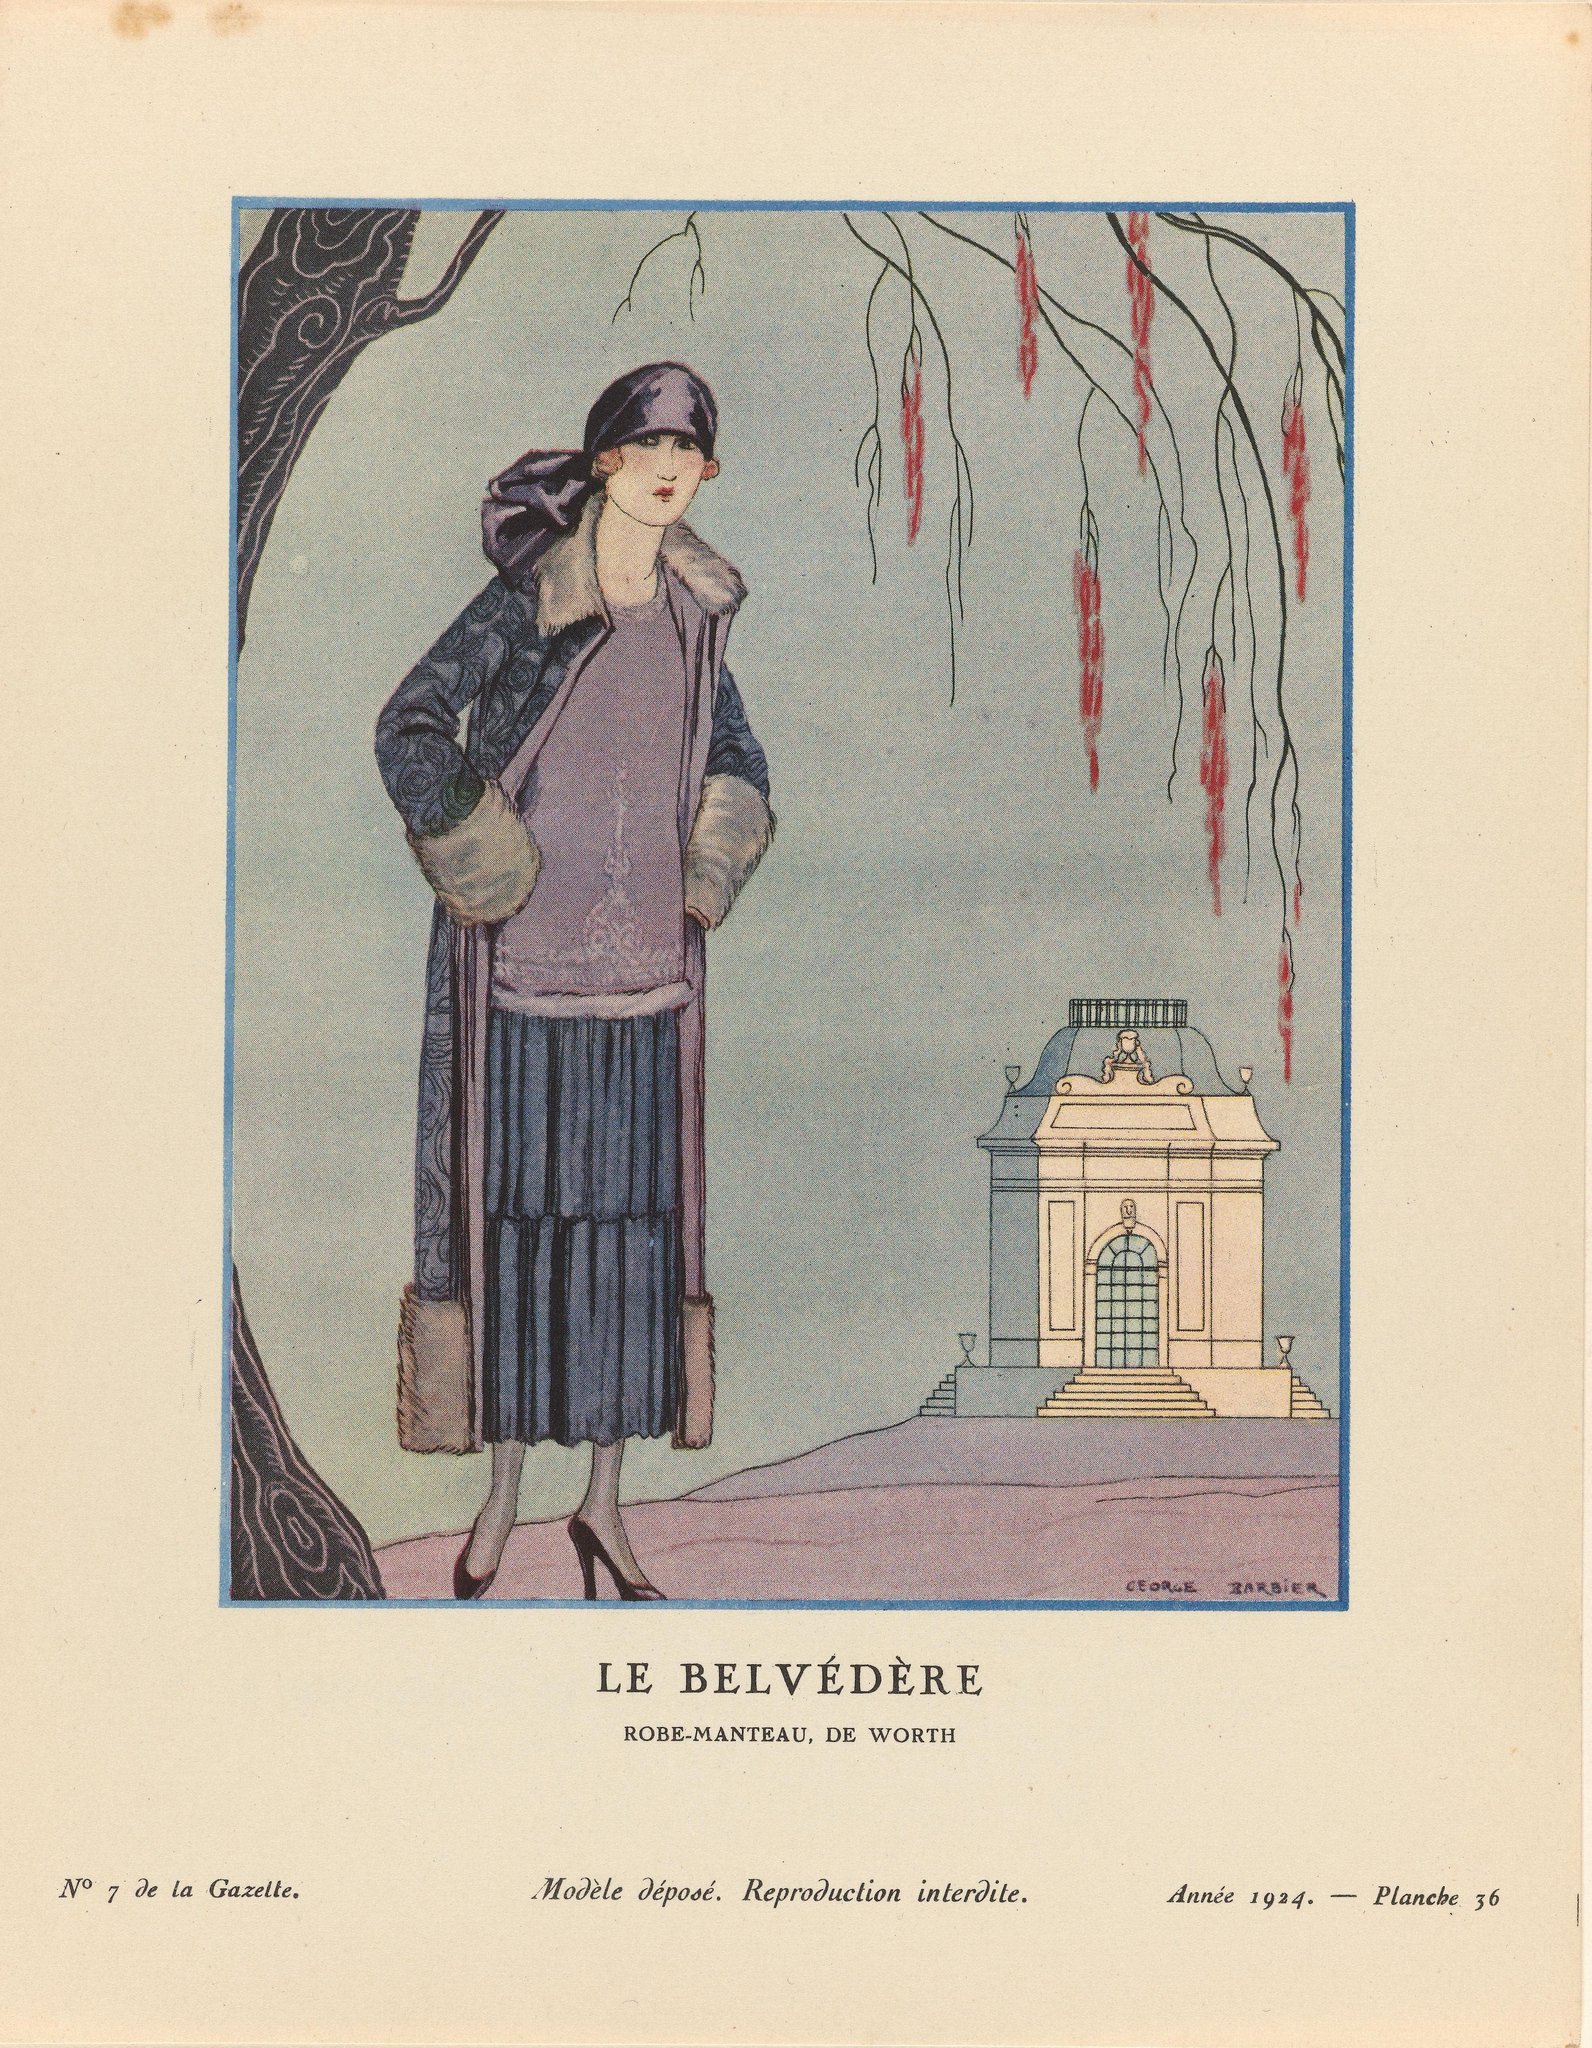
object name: fashion print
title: Gazette du Bon Ton. Art- Modes & Frivolités, 1924 - No. 7 : Le Belvédère / Robe-Manteau, de Worth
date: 1924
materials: paper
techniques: printing, letterpress printing, photochemical processes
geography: paris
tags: head-gear (+ women's clothes), fashion plates, dress, gown (+ women's clothes), belvedere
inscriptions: caption: ‘Modèle déposé. Reproduction interdite.’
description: Staande vrouw gekleed in een japon met een geplooide rok en een mantel afgezet met bont, van Worth. Om het hoofd een doek. Op de achtergrond een belvédère. Planche 36 uit Gazette du Bon Ton 1924, No. 7.